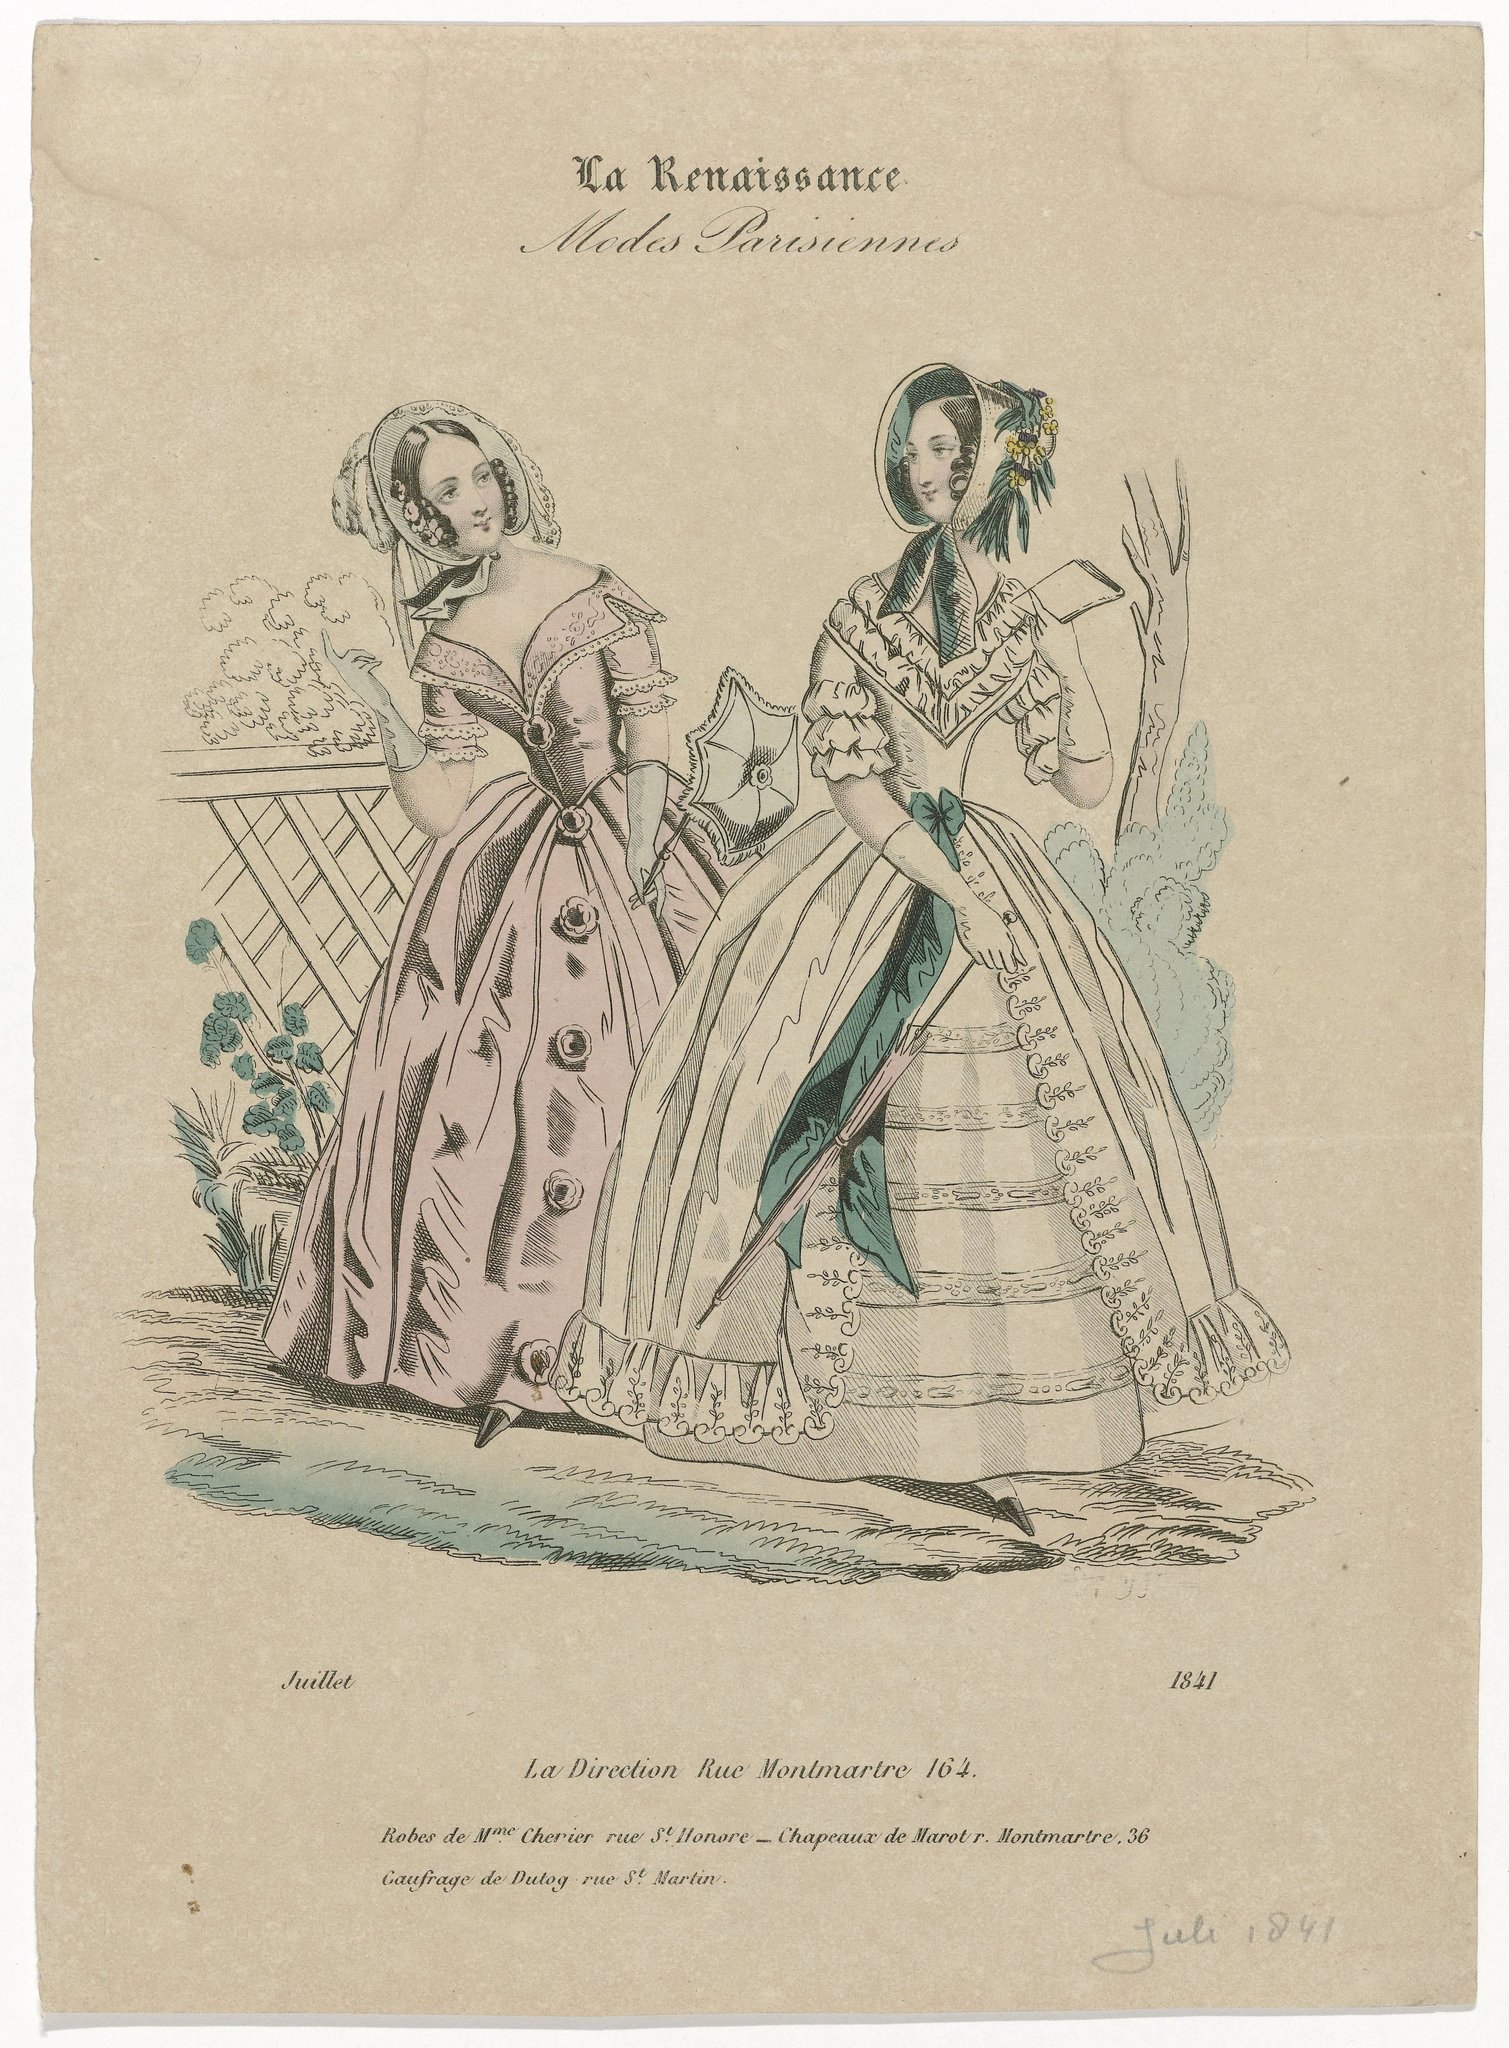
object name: fashion print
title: La Renaissance, juillet 1841 : Robes de Mme Cherier (...)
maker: Anonymous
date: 1841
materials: paper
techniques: engraving, hand coloring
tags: gloves, mittens (long gloves) (+ women's clothes), ornamental parts of clothing (+ women's clothes), fashion plates, head-gear: hat (+ women's clothes), shoes, sandals (+ women's clothes), dress, gown (+ women's clothes), book, parasol, sunshade (+ women's clothes)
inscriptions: address: ‘La Direction Rue Montmartre 164.’, caption: ‘Robes de M.me Cherier rue St. honore_chapeaux de Marot r. Montmartre, 36 Gaufrage de Dutog rue S.t Martin.’, title: ‘La Renaissance / Modes Parisiennes’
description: Twee vrouwen bij een hek, van wie één met een parasol met een gekanteld dek in de hand. Volgens het onderschrift: japonnen van Cherier. Hoeden van Marot. 'Gaufrage' van Dutog. Prent uit het modetijdschrift La Renaissance (1840-1842).